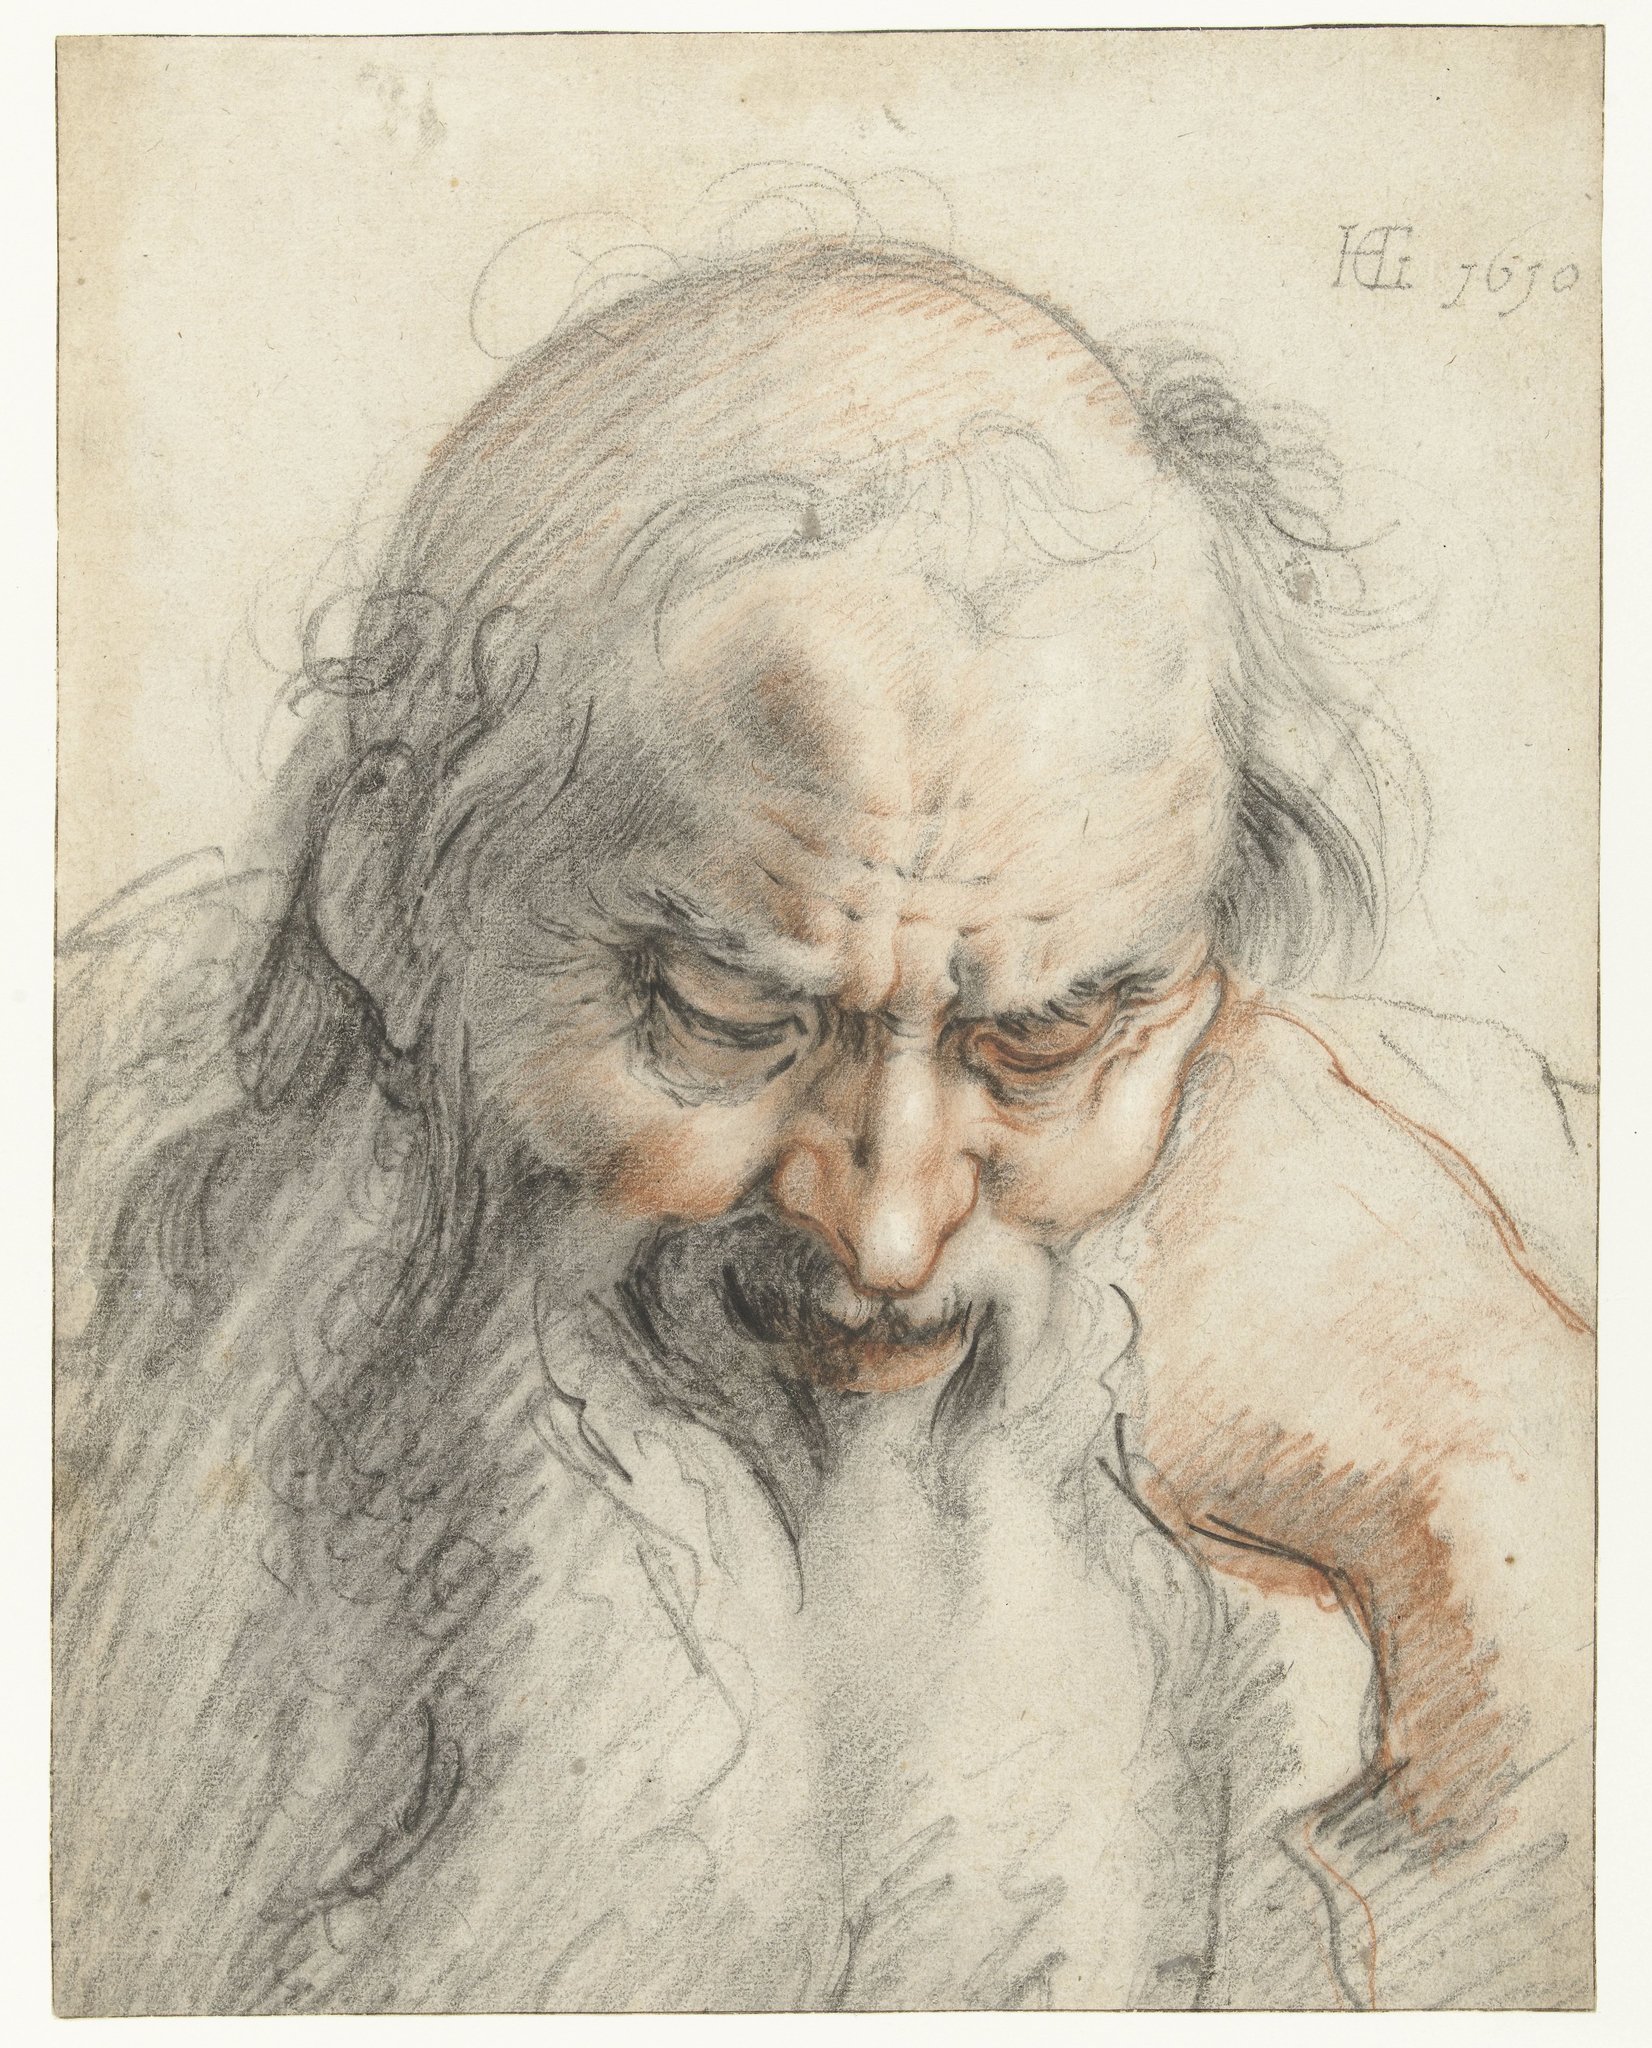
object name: drawing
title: Buste van een oude man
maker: hendrick goltzius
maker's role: draughtsman, painter, print maker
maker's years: 1558-1617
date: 1610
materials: chalk, paper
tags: old man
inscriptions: date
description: Dit is één van de meest uitstekende studies van het latere werk van Goltzius, waarmee de kunstenaar weer zijn aandacht vestigt op het tekenaarschap van Baroccio en Zuccaro. Het is waarschijnlaijk naar model getekend en Reznicek's vermoeden dat het gaat om een portret van de vader van Goltzius, Jan Goltz, lijkt aannemelijk vergeleken met de prent van 1578, voorstellende Jan Goltz (B 171). Jan Goltz leefde nog in 1609.